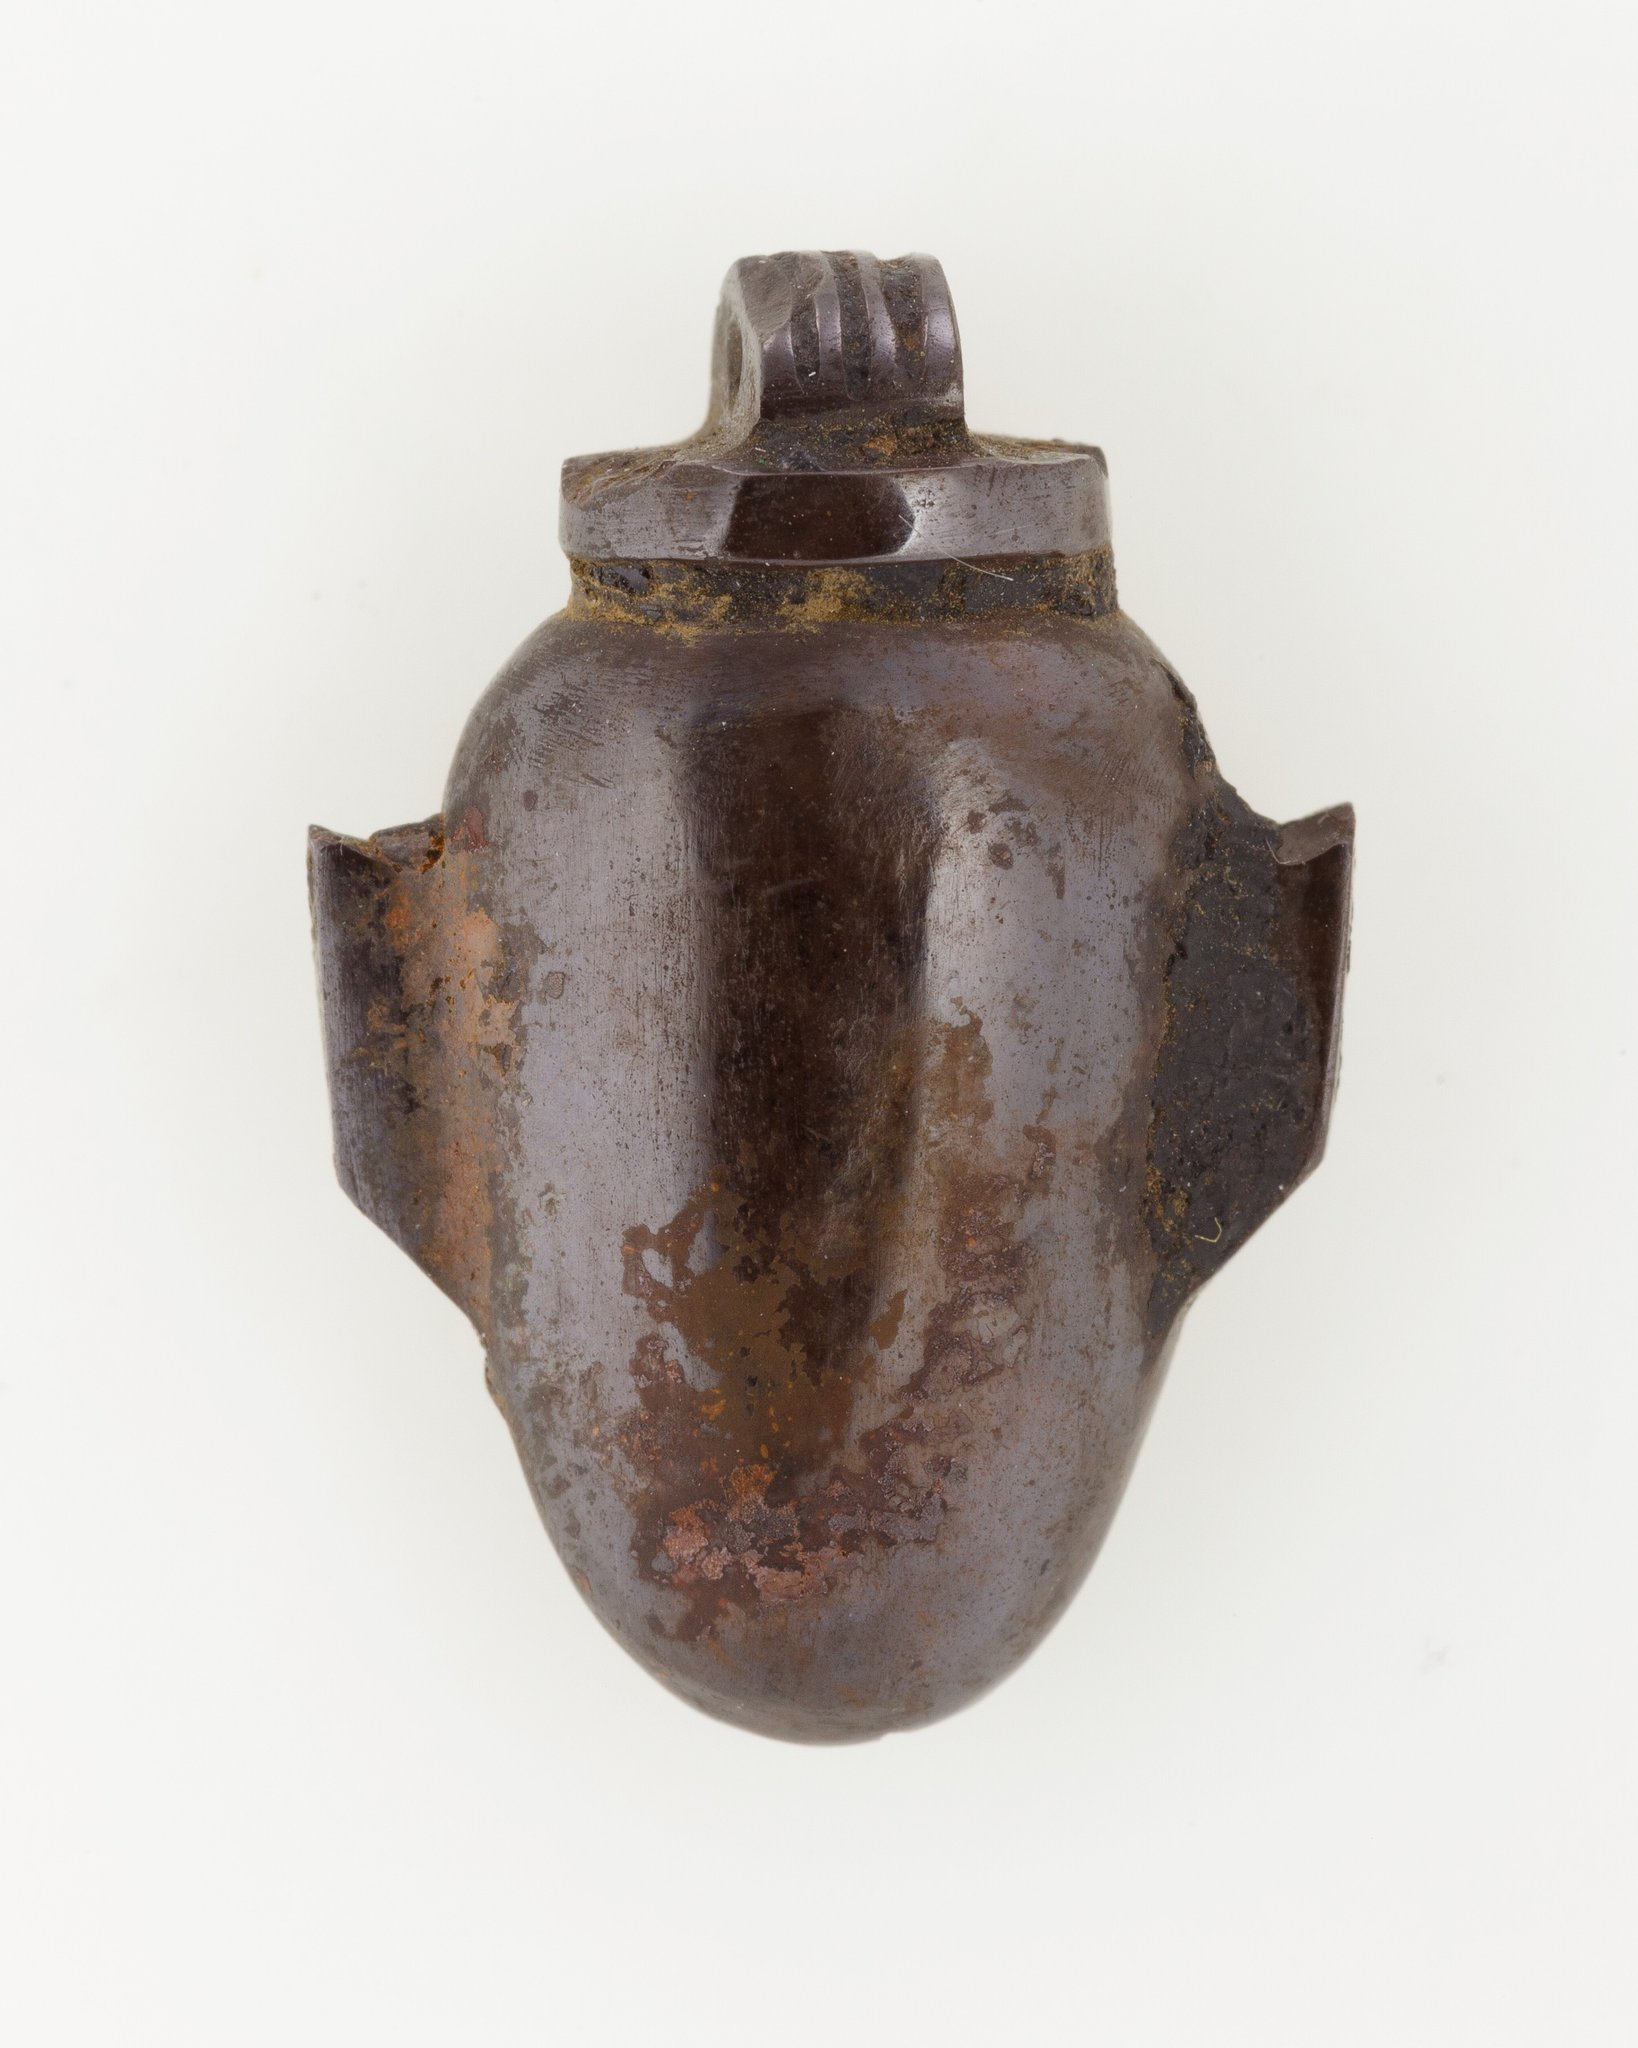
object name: amulet, heart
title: Heart amulet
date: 664-332 BCE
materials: mineral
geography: egypt